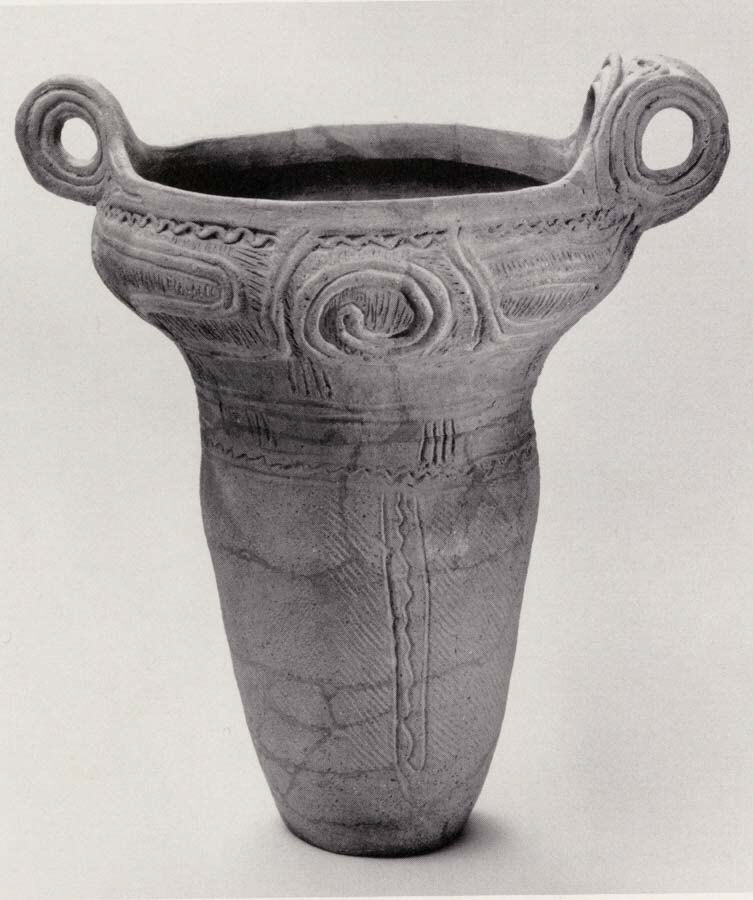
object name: vessel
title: Deep Vessel with Handles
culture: japanese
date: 3500-2500 BCE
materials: cord, earthenware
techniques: incising